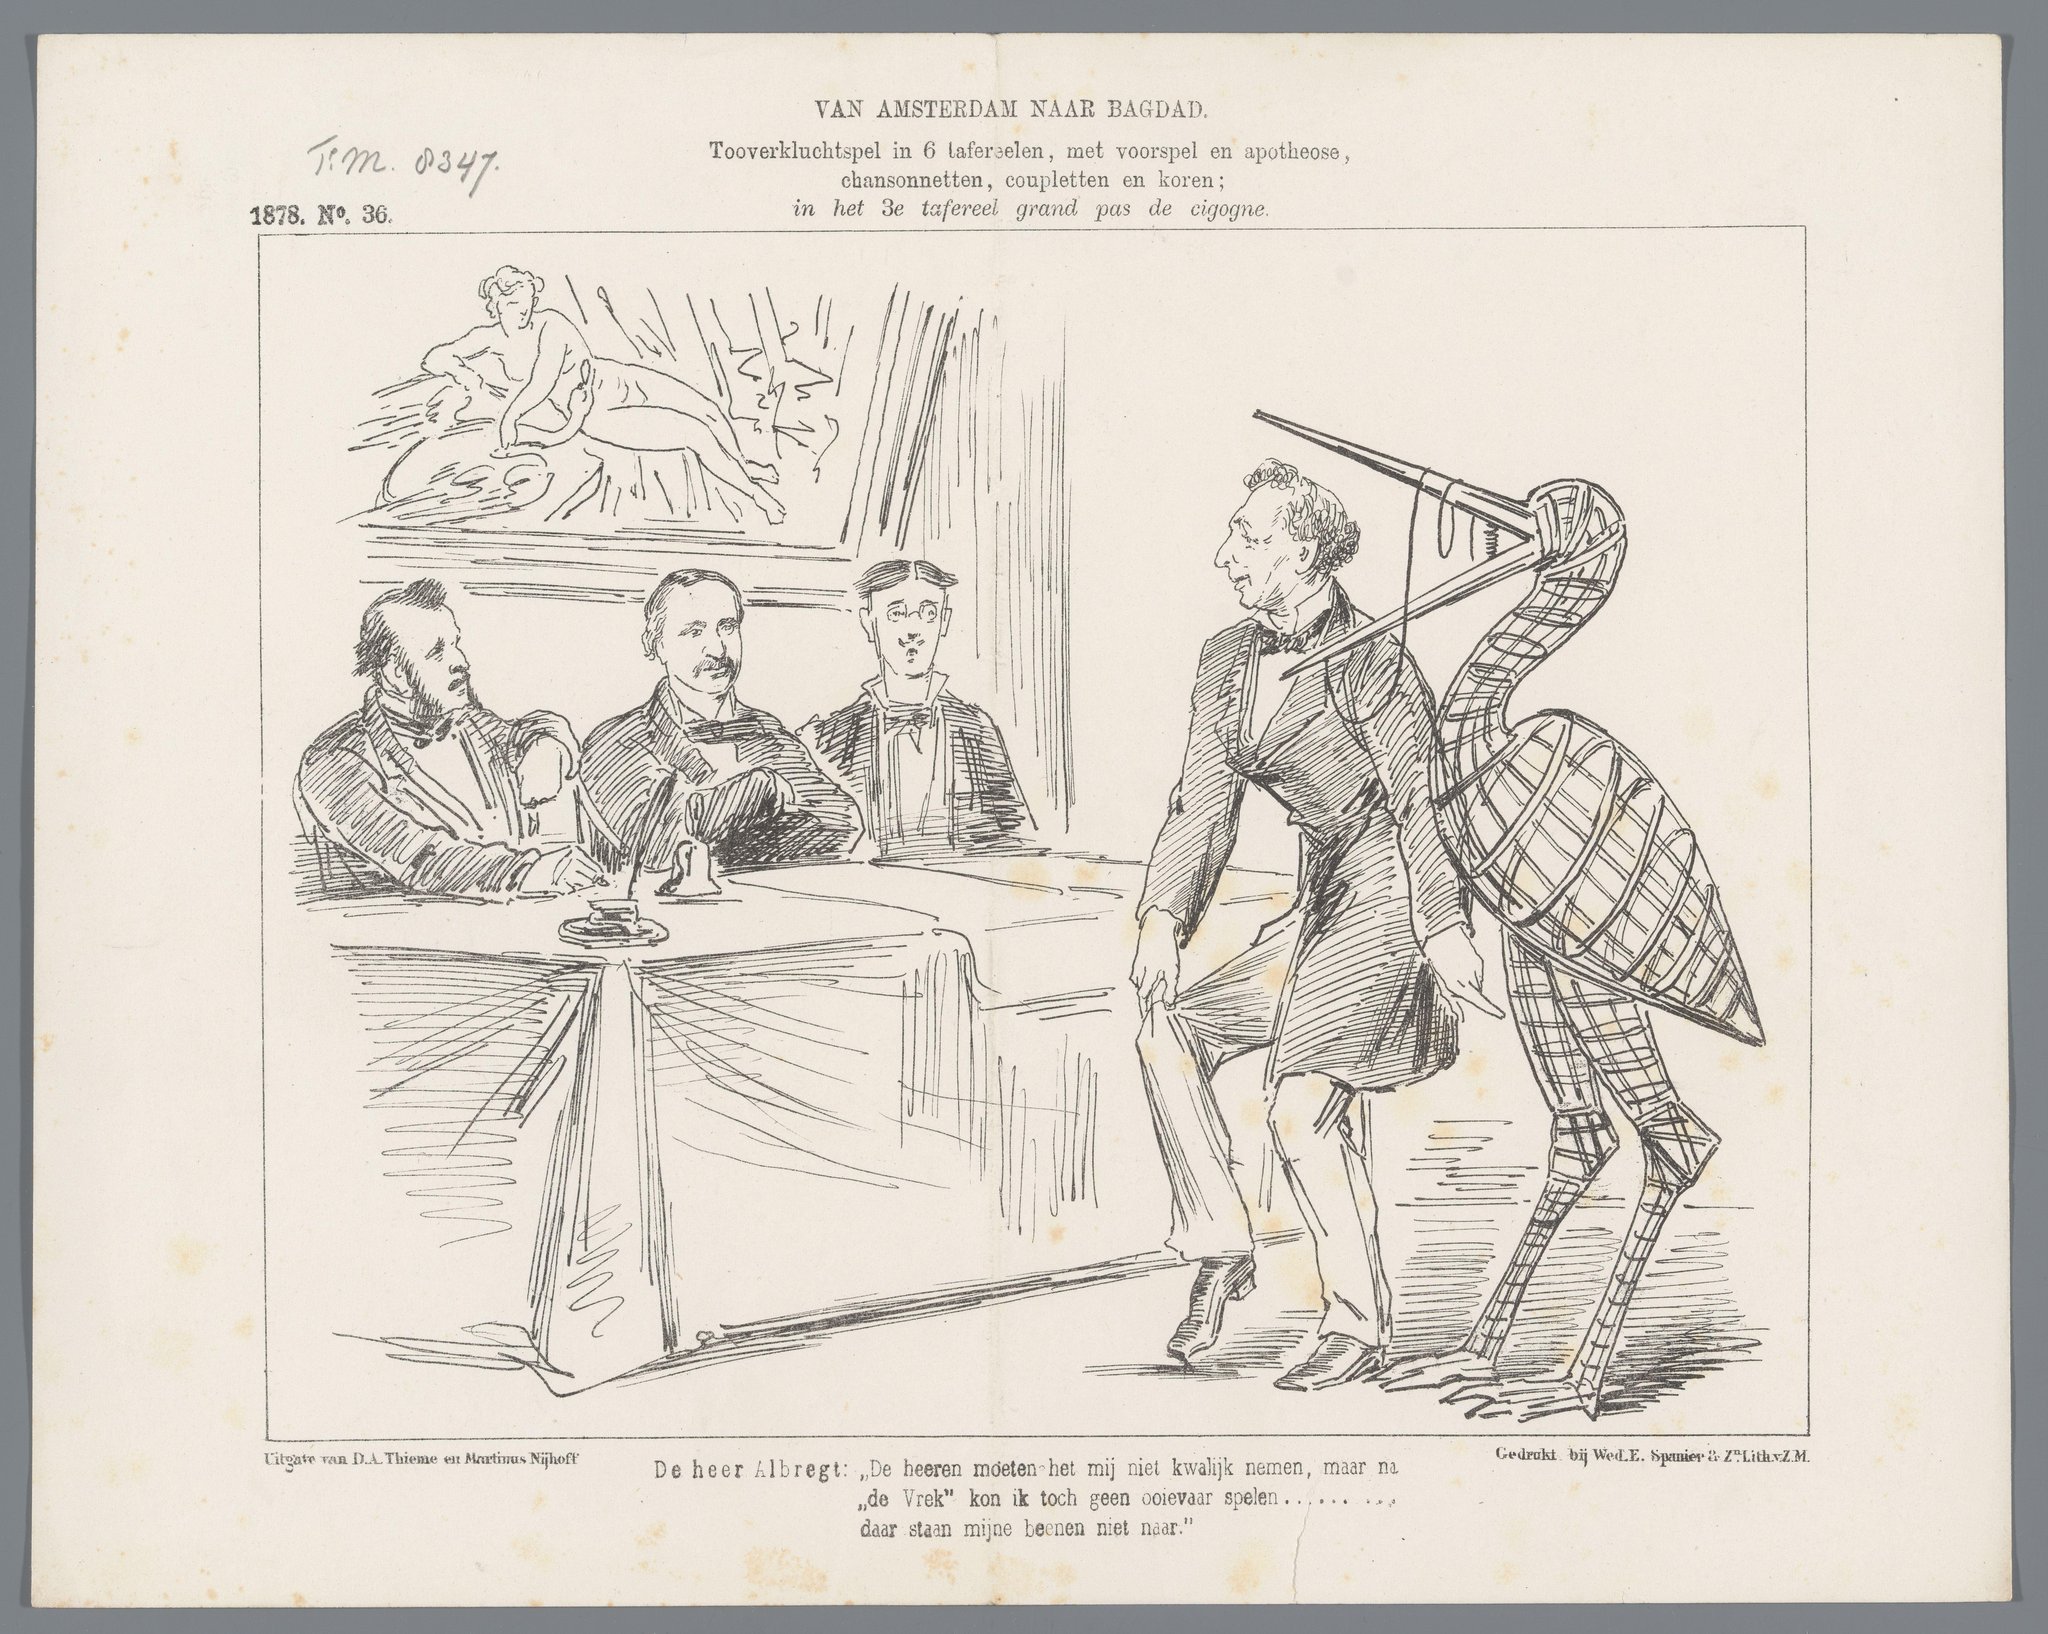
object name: cartoon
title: Van Amsterdam naar Bagdad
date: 1878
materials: paper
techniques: lithograph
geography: netherlands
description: Spotprent. Plaat verschenen bij het weekblad De Nederlandsche Spectator, nr. 36, 1878.